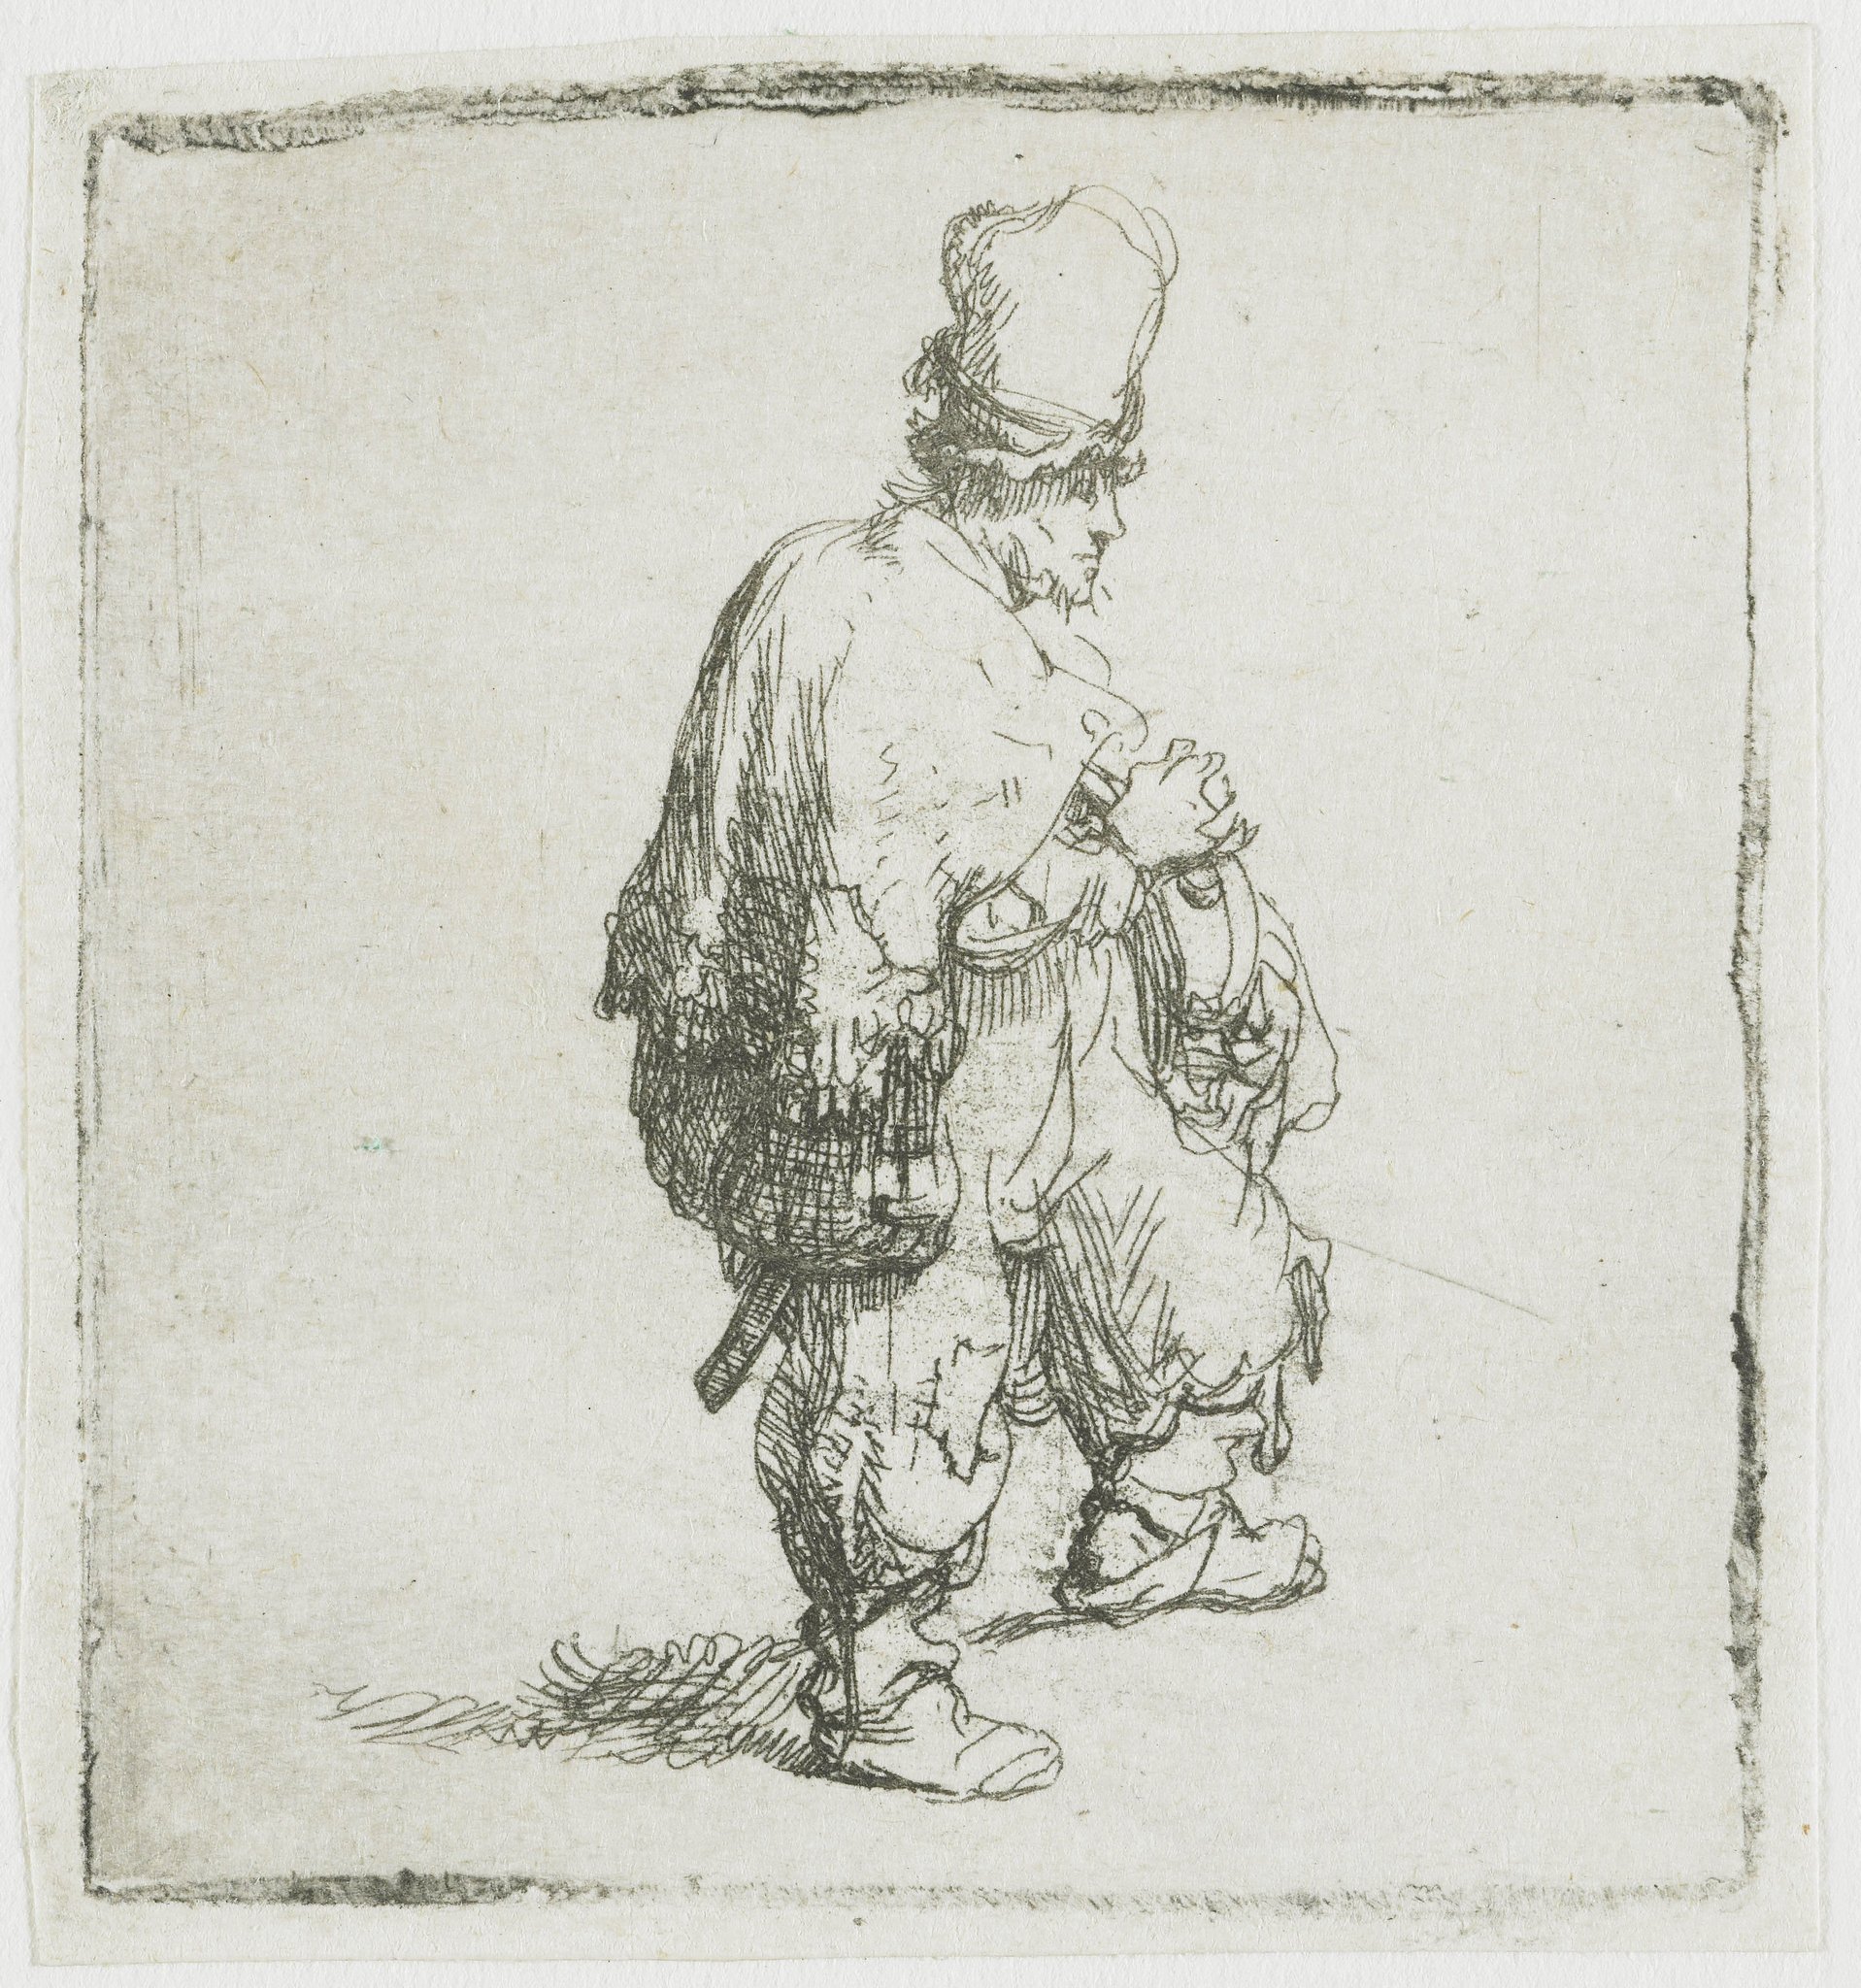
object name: print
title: A standing hurdy-gurdy player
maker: rembrandt van rijn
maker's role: draughtsman, painter, print maker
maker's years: 1606-1669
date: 1631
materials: paper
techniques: etching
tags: barrel-organ player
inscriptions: collector's mark: Lugt 240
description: Initially, Rembrandt was fascinated above all by pathetic wretches compelled to beg for alms. Later, he also developed an interest in other colourful city folk, which he usually depicted in the same minuscule format. In these six etchings, he portrayed a quack in outmoded clothing, two Polish soldiers, two street musicians (an organ grinder and a fiddler) and a skater.